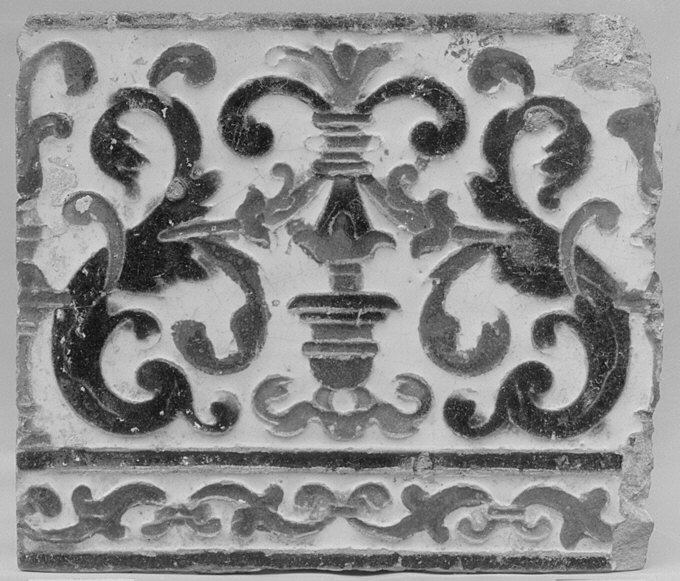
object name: tile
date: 1501-1600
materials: earthenware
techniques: glazing